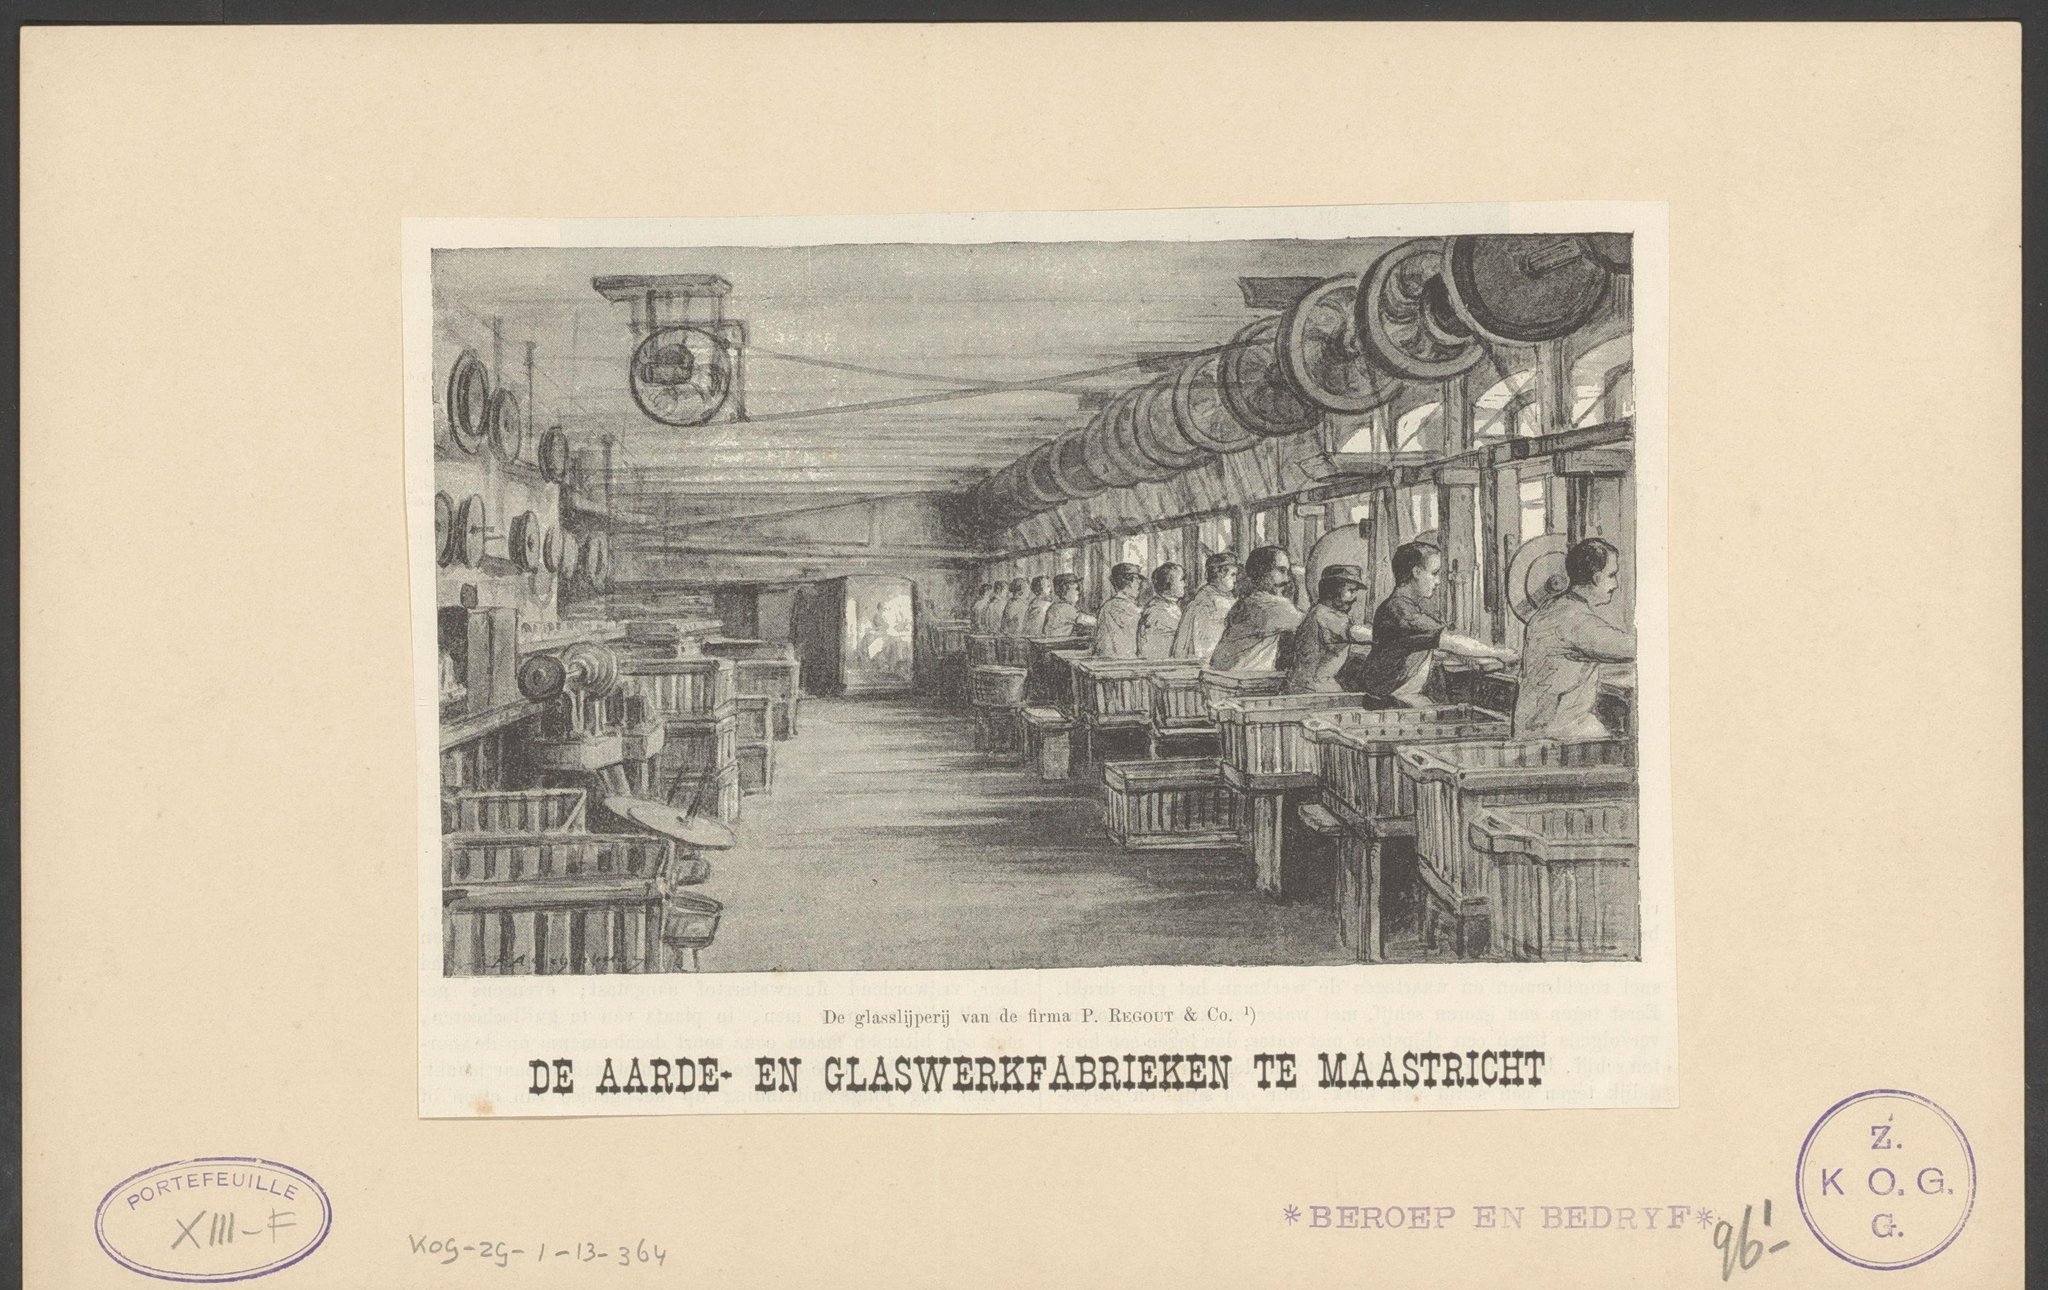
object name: photomechanical print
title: Glasslijperij van de firma P. Regout & Co te Maastricht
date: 1887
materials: paper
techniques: letterpress printing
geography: haarlem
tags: factory-building, polishing (industrial process), maastricht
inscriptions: stamp, stamp, collector's mark: Lugt 1641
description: Onderwerpsrubrieken binnen de Atlas Zeden en Gewoonten: Handel, Nijverheid en verkeer, Beroep en bedrijf, Mannelijk, Glas en Aardewerk.